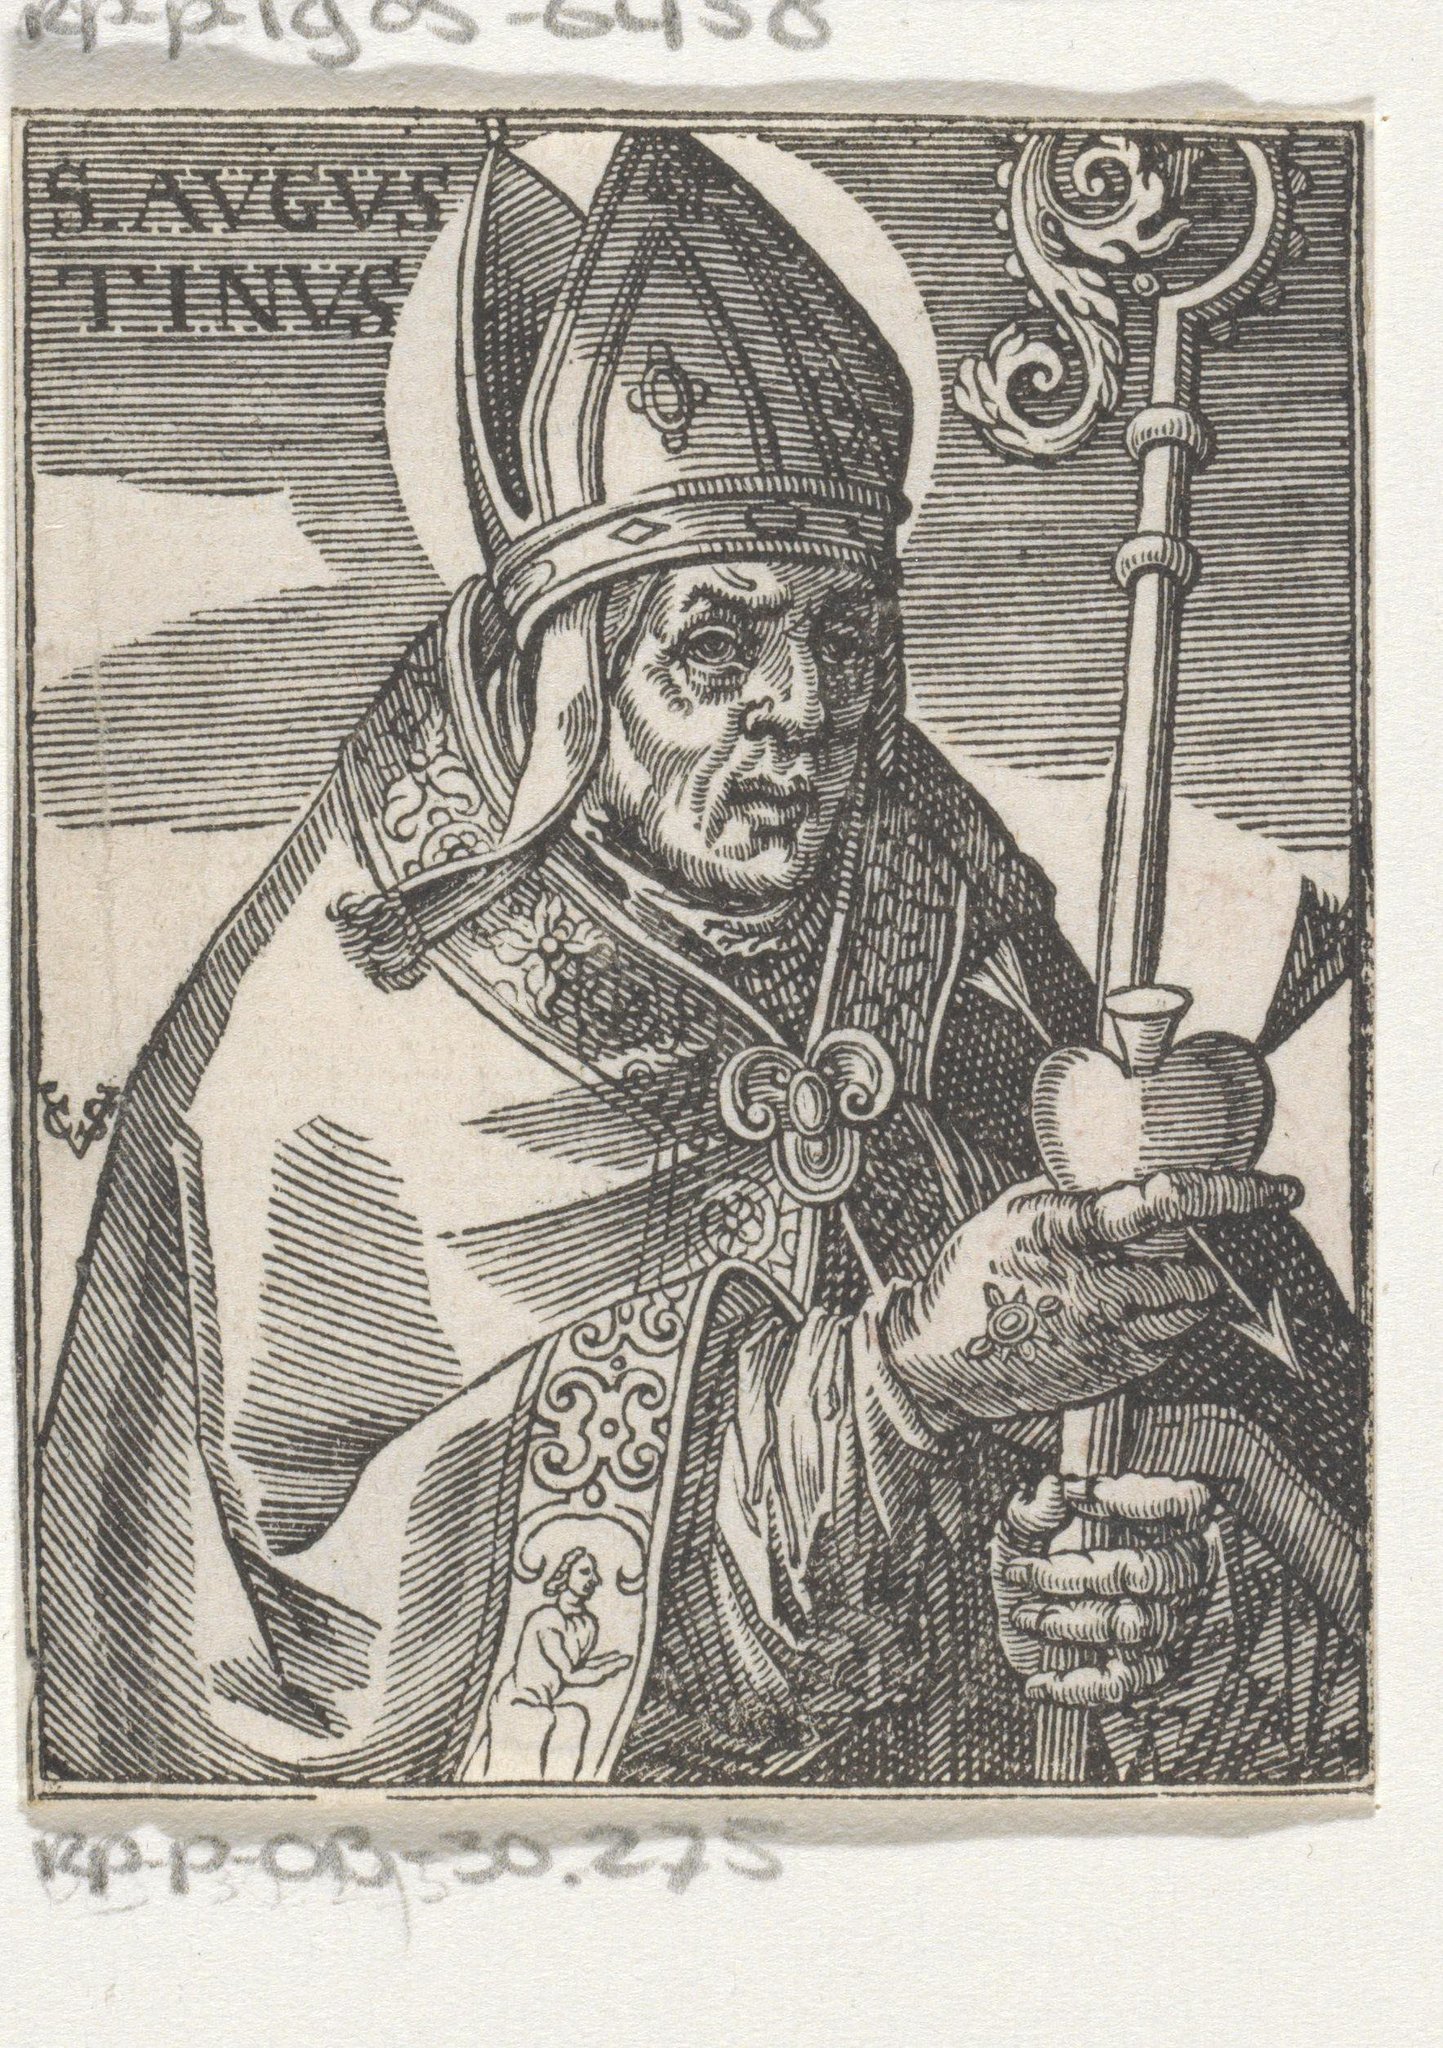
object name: print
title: Heilige Augustinus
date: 1648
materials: paper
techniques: woodcut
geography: amsterdam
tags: augustine, bishop of hippo; possible attributes: arrows piercing his breast, book, child with spoon, flaming heart, heart (pierced with arrows), pen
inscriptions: collector's mark: Lugt 240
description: Prent uit: Sichem, Christoffel van (II). 'tSchat der zielen, dat is: Het geheele leven ons Heeren Iesu Christi. Amsterdam: Pieter Jacobsz. Paets, 1648.